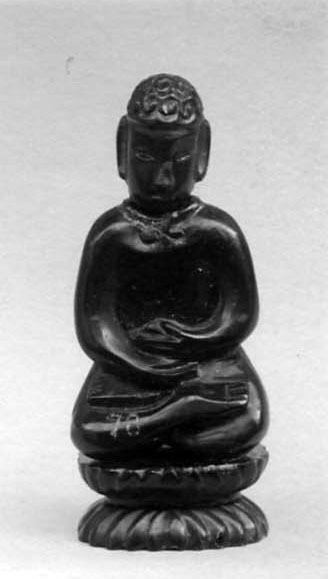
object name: figurine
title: Figure of a Buddha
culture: chinese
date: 1736-1795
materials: amber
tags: buddha